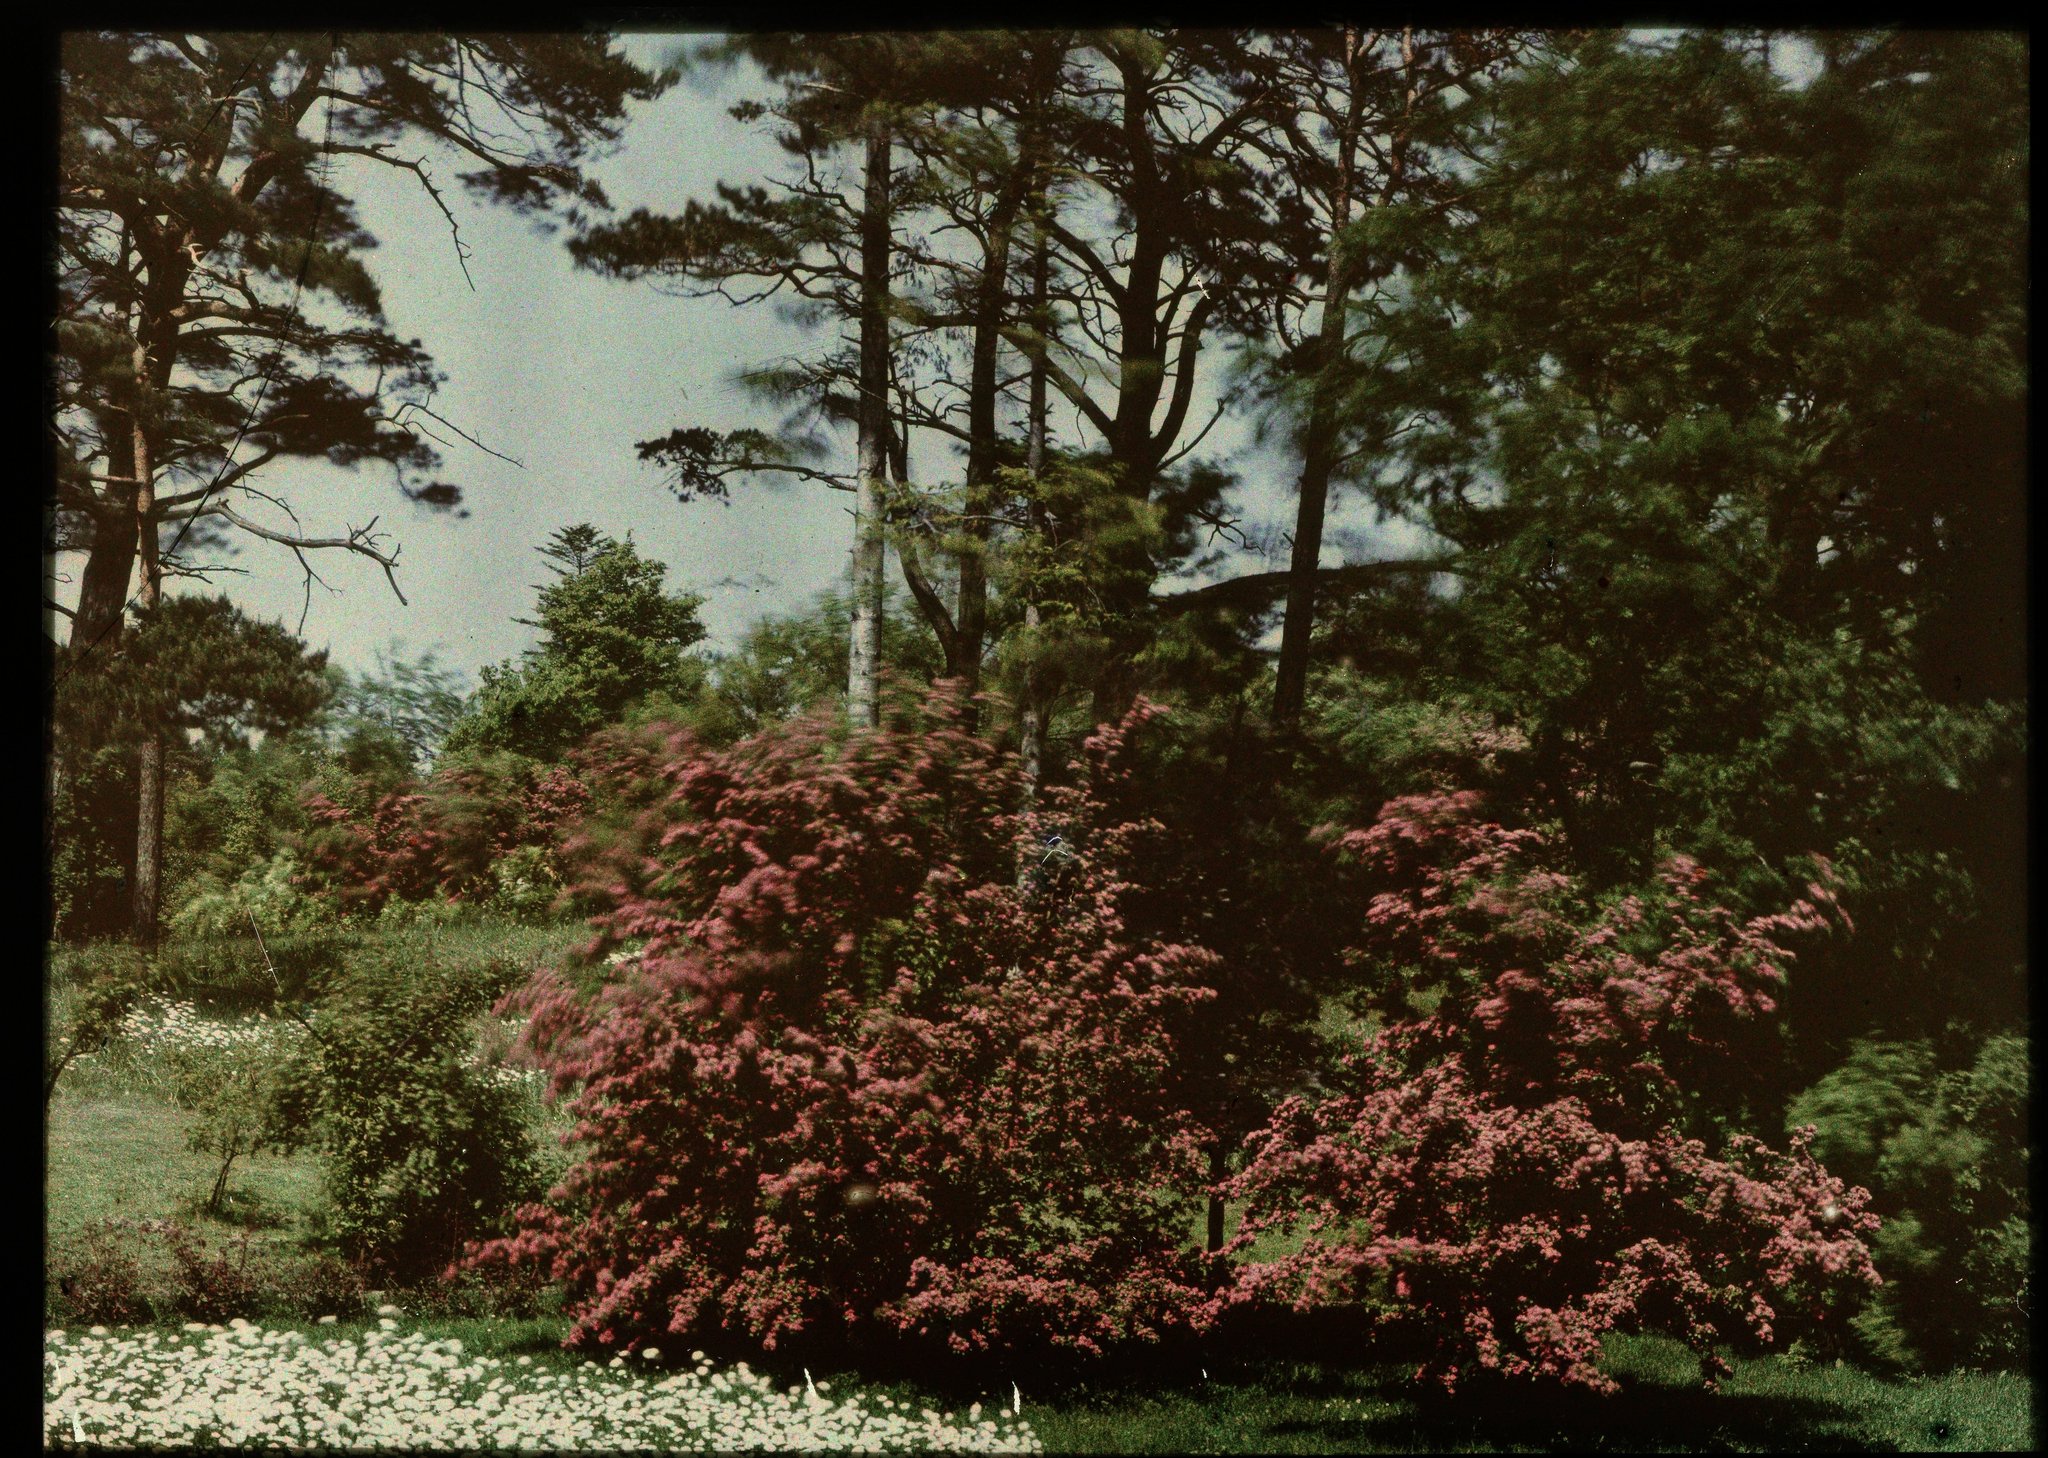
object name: color slide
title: Gezicht in een park of tuin, met madeliefjes in het gras (voorgrond), een rood bloeiende struik en bomen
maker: adolphe burdet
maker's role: fotograaf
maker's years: 1860-1940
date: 1907-1930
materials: glass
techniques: autochrome process, slide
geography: netherlands